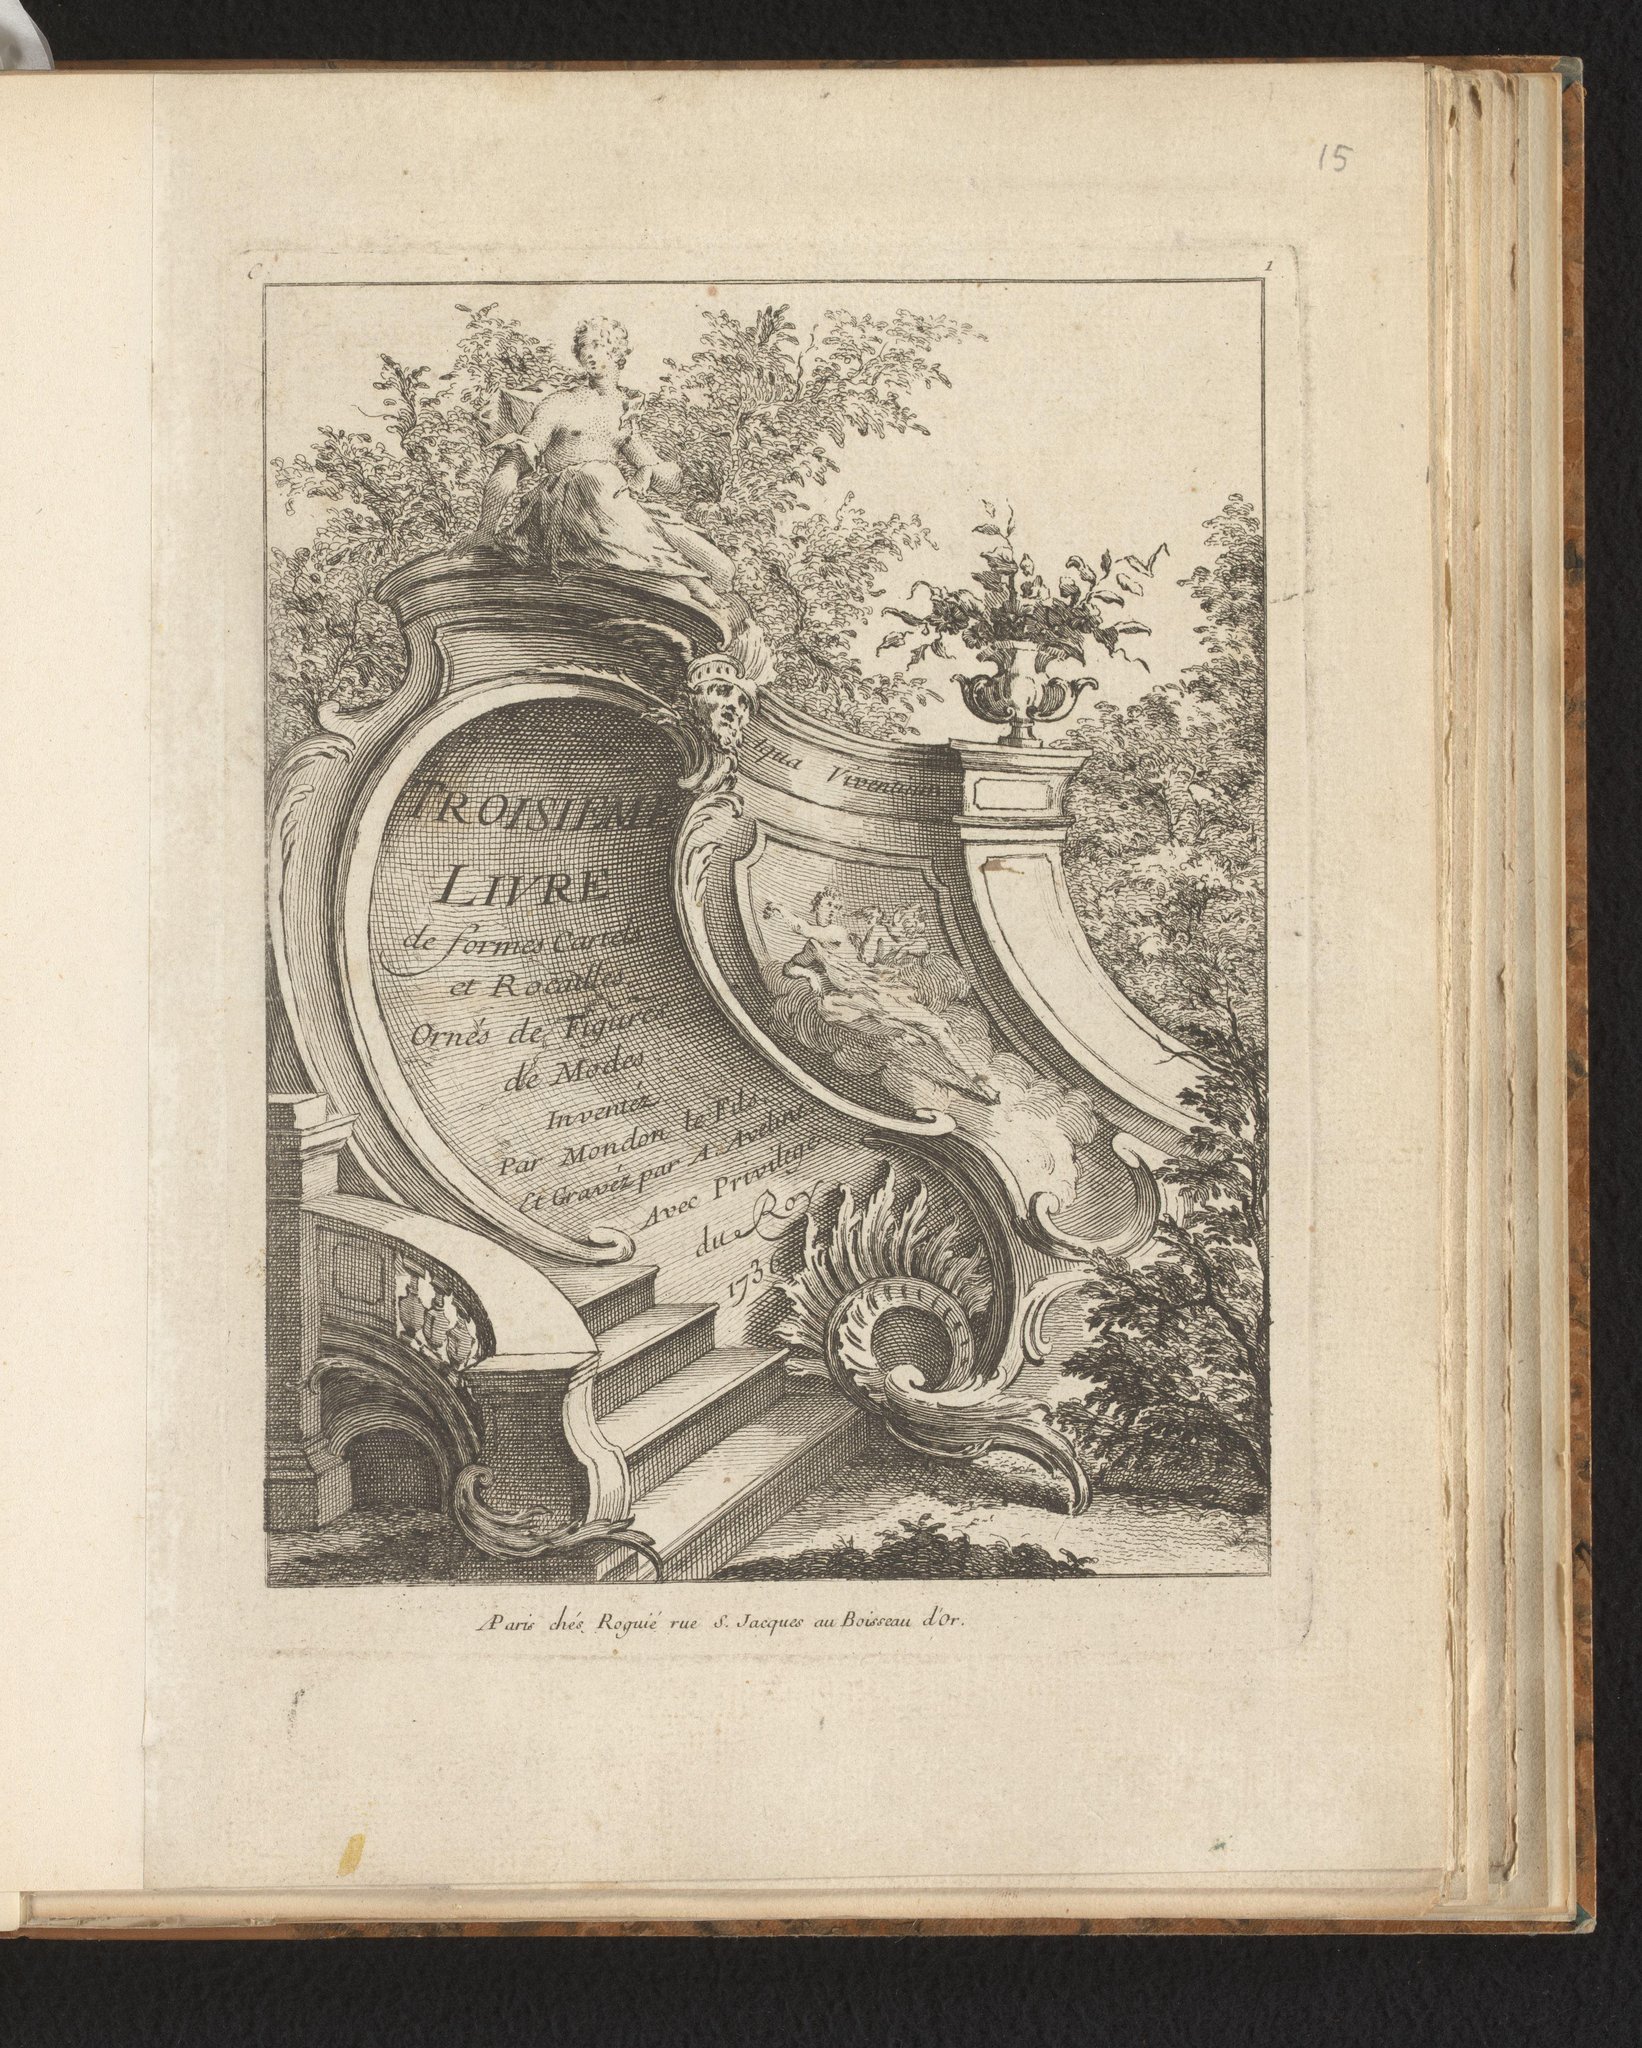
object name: titelprent, frontispice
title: Titelprent met rocaille op bordestrap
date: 1736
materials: paper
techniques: etching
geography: france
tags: rocaille ornament, terrace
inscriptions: date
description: Deze serie is linksboven genummerd met een letter C. Prent maakt deel uit van een album.